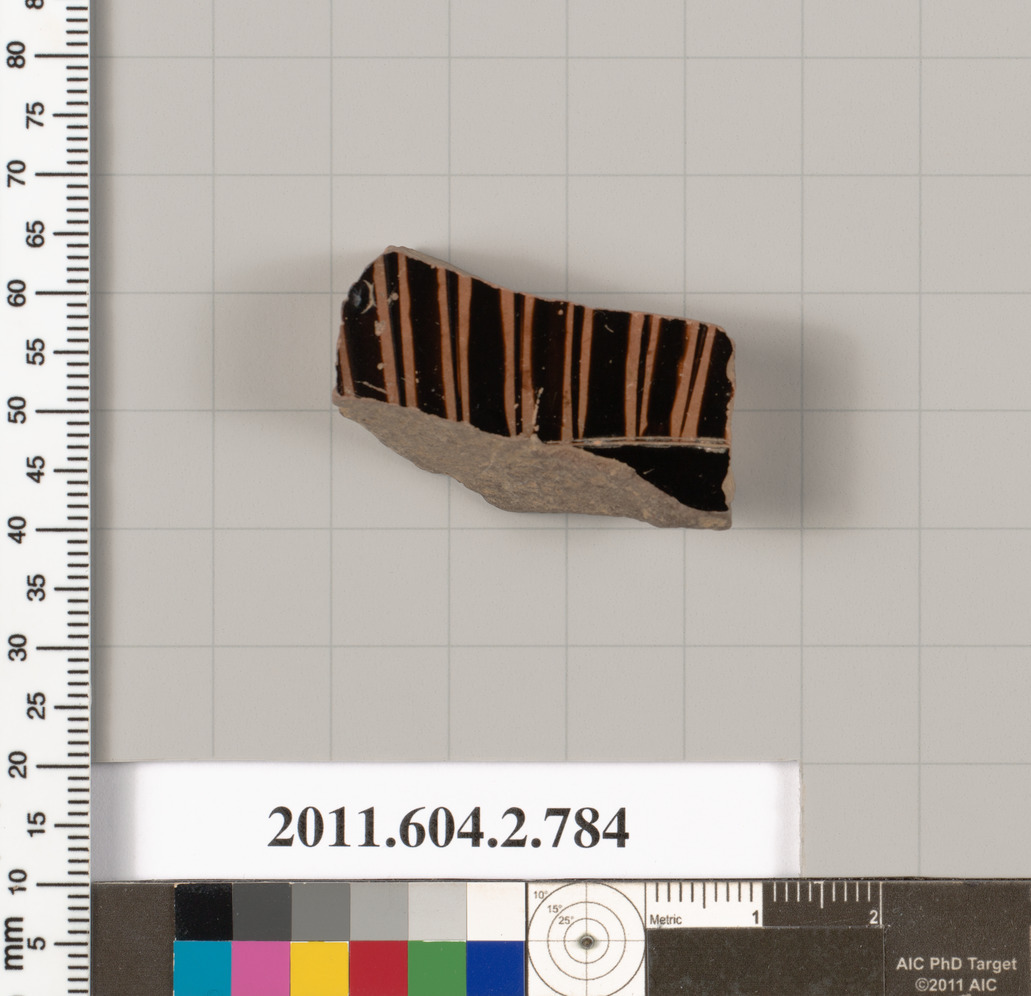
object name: calyx krater fragment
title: Terracotta fragment of a calyx-krater (bowl for mixing wine and water)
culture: greek, attic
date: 475-451 BCE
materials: terracotta